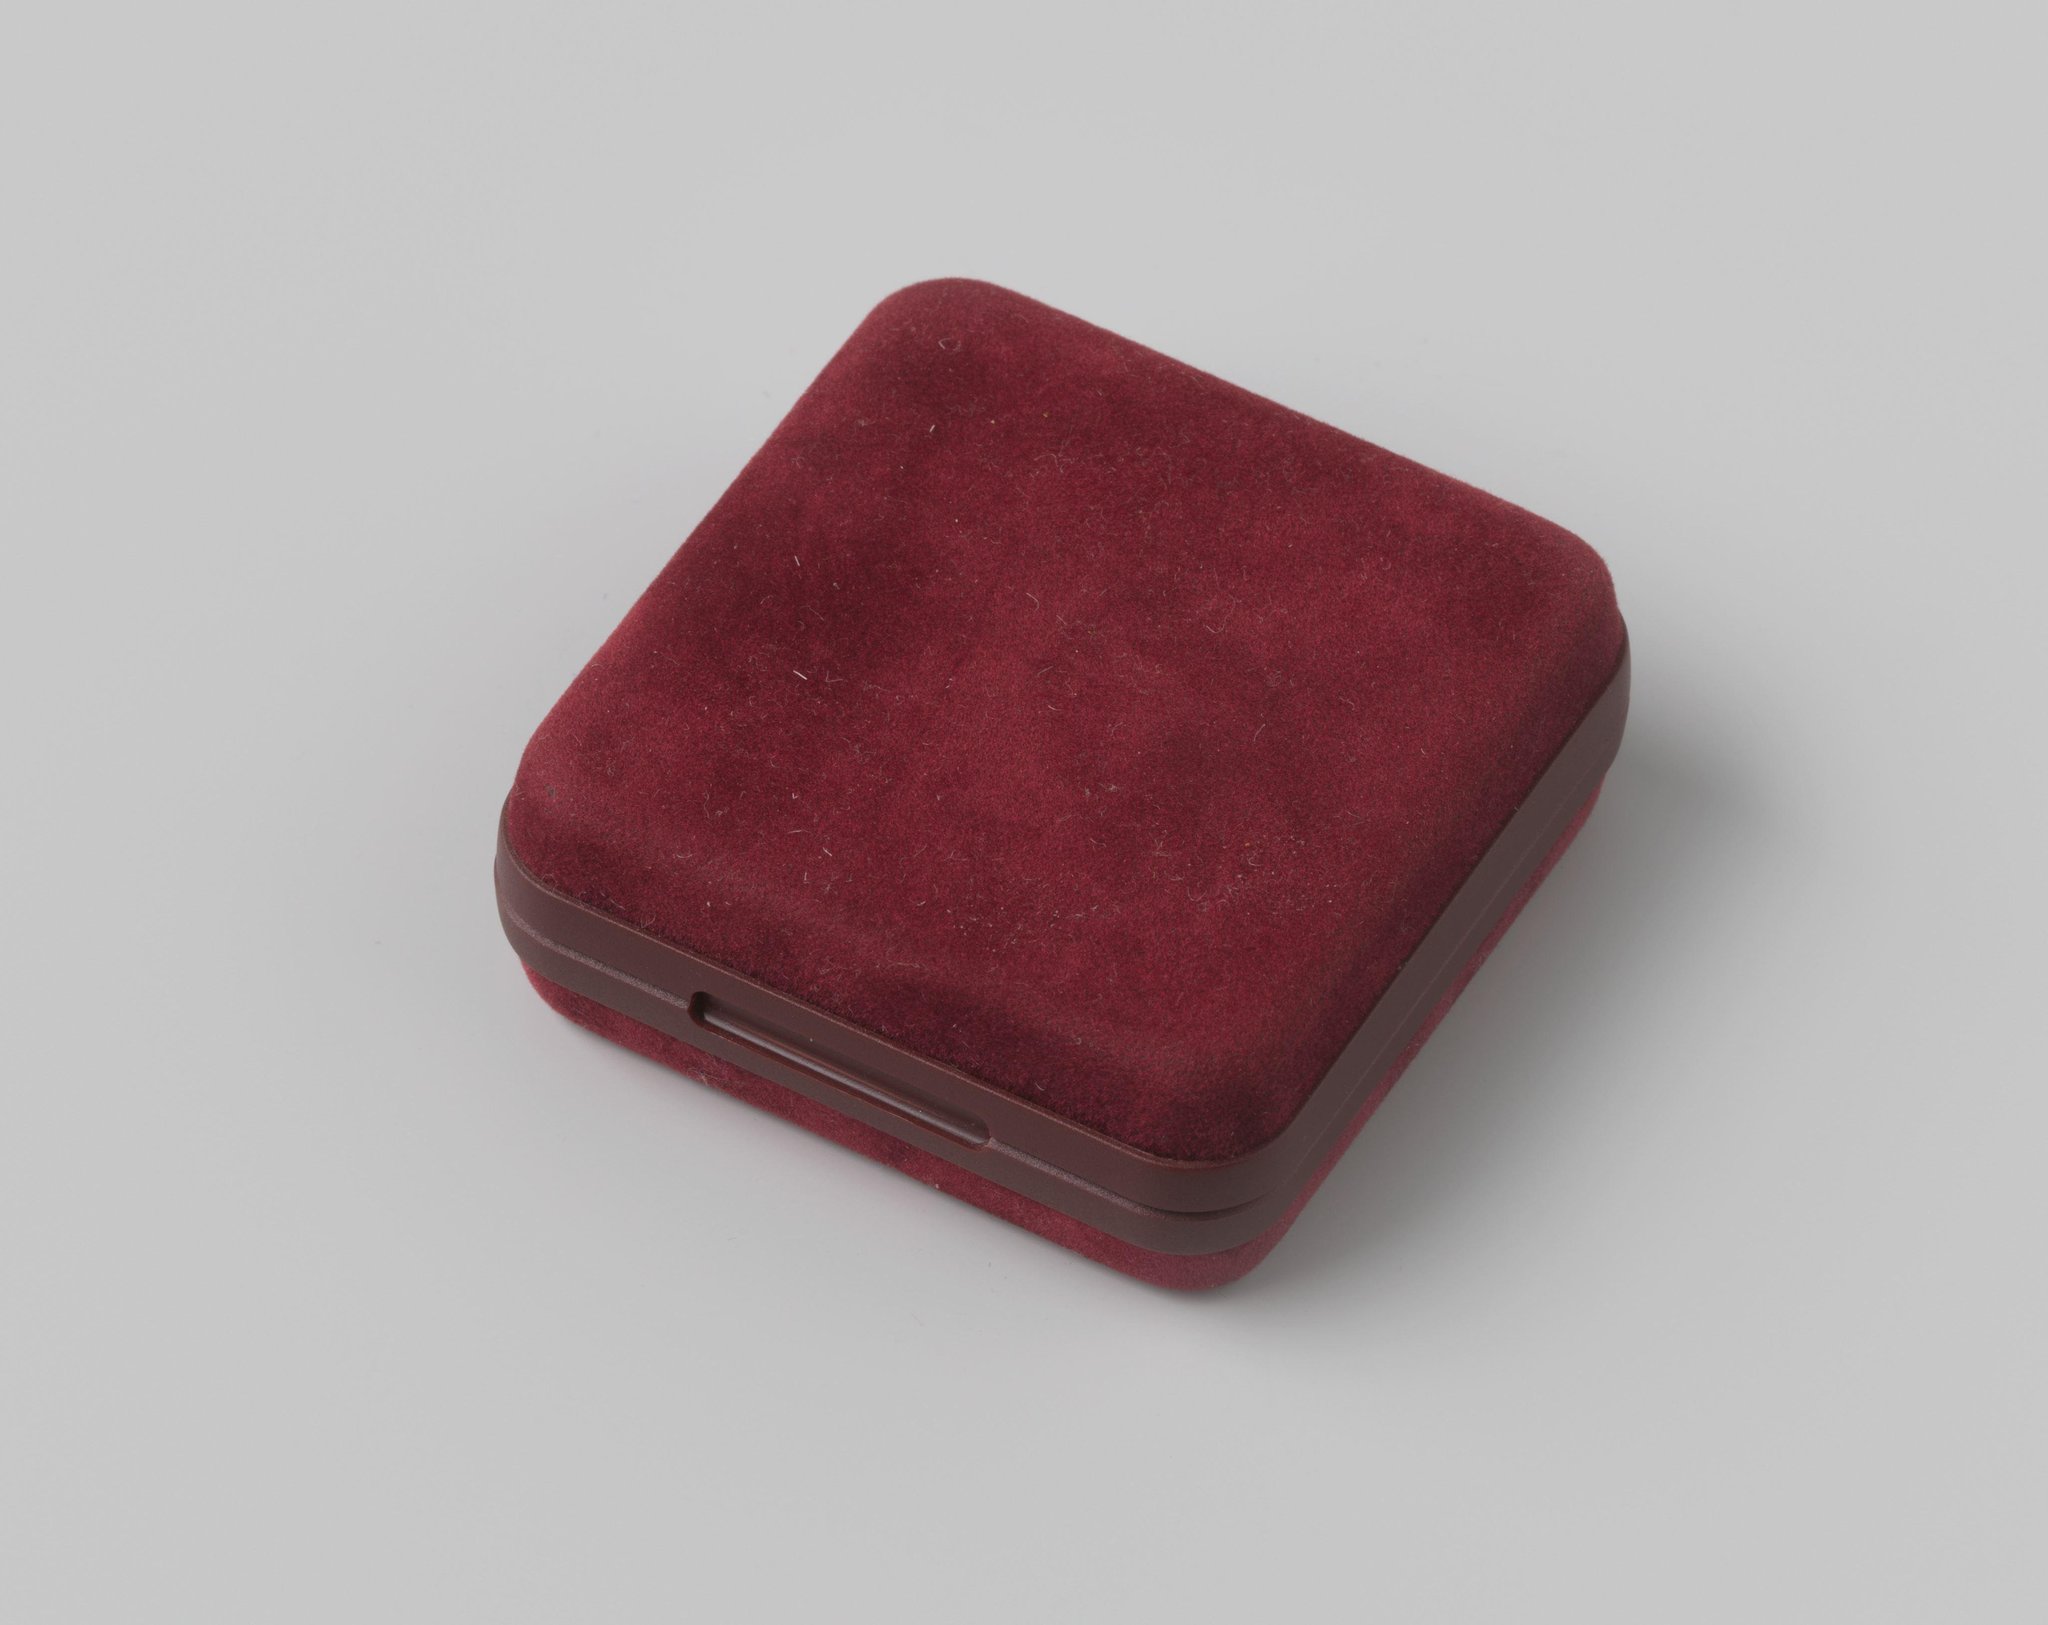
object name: box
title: Doosje van Ecu der Nederlanden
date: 1992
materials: plastic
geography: elst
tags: utrecht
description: Donkerrood fluwelen doosje voor munt 'Ecu der Nederlanden' (NG-1992-5-A), in het doosje zit tevens een certificaat. Doosje heeft ronde uitsparing om munt (in plastic hoesje) te kunnen opbergen.